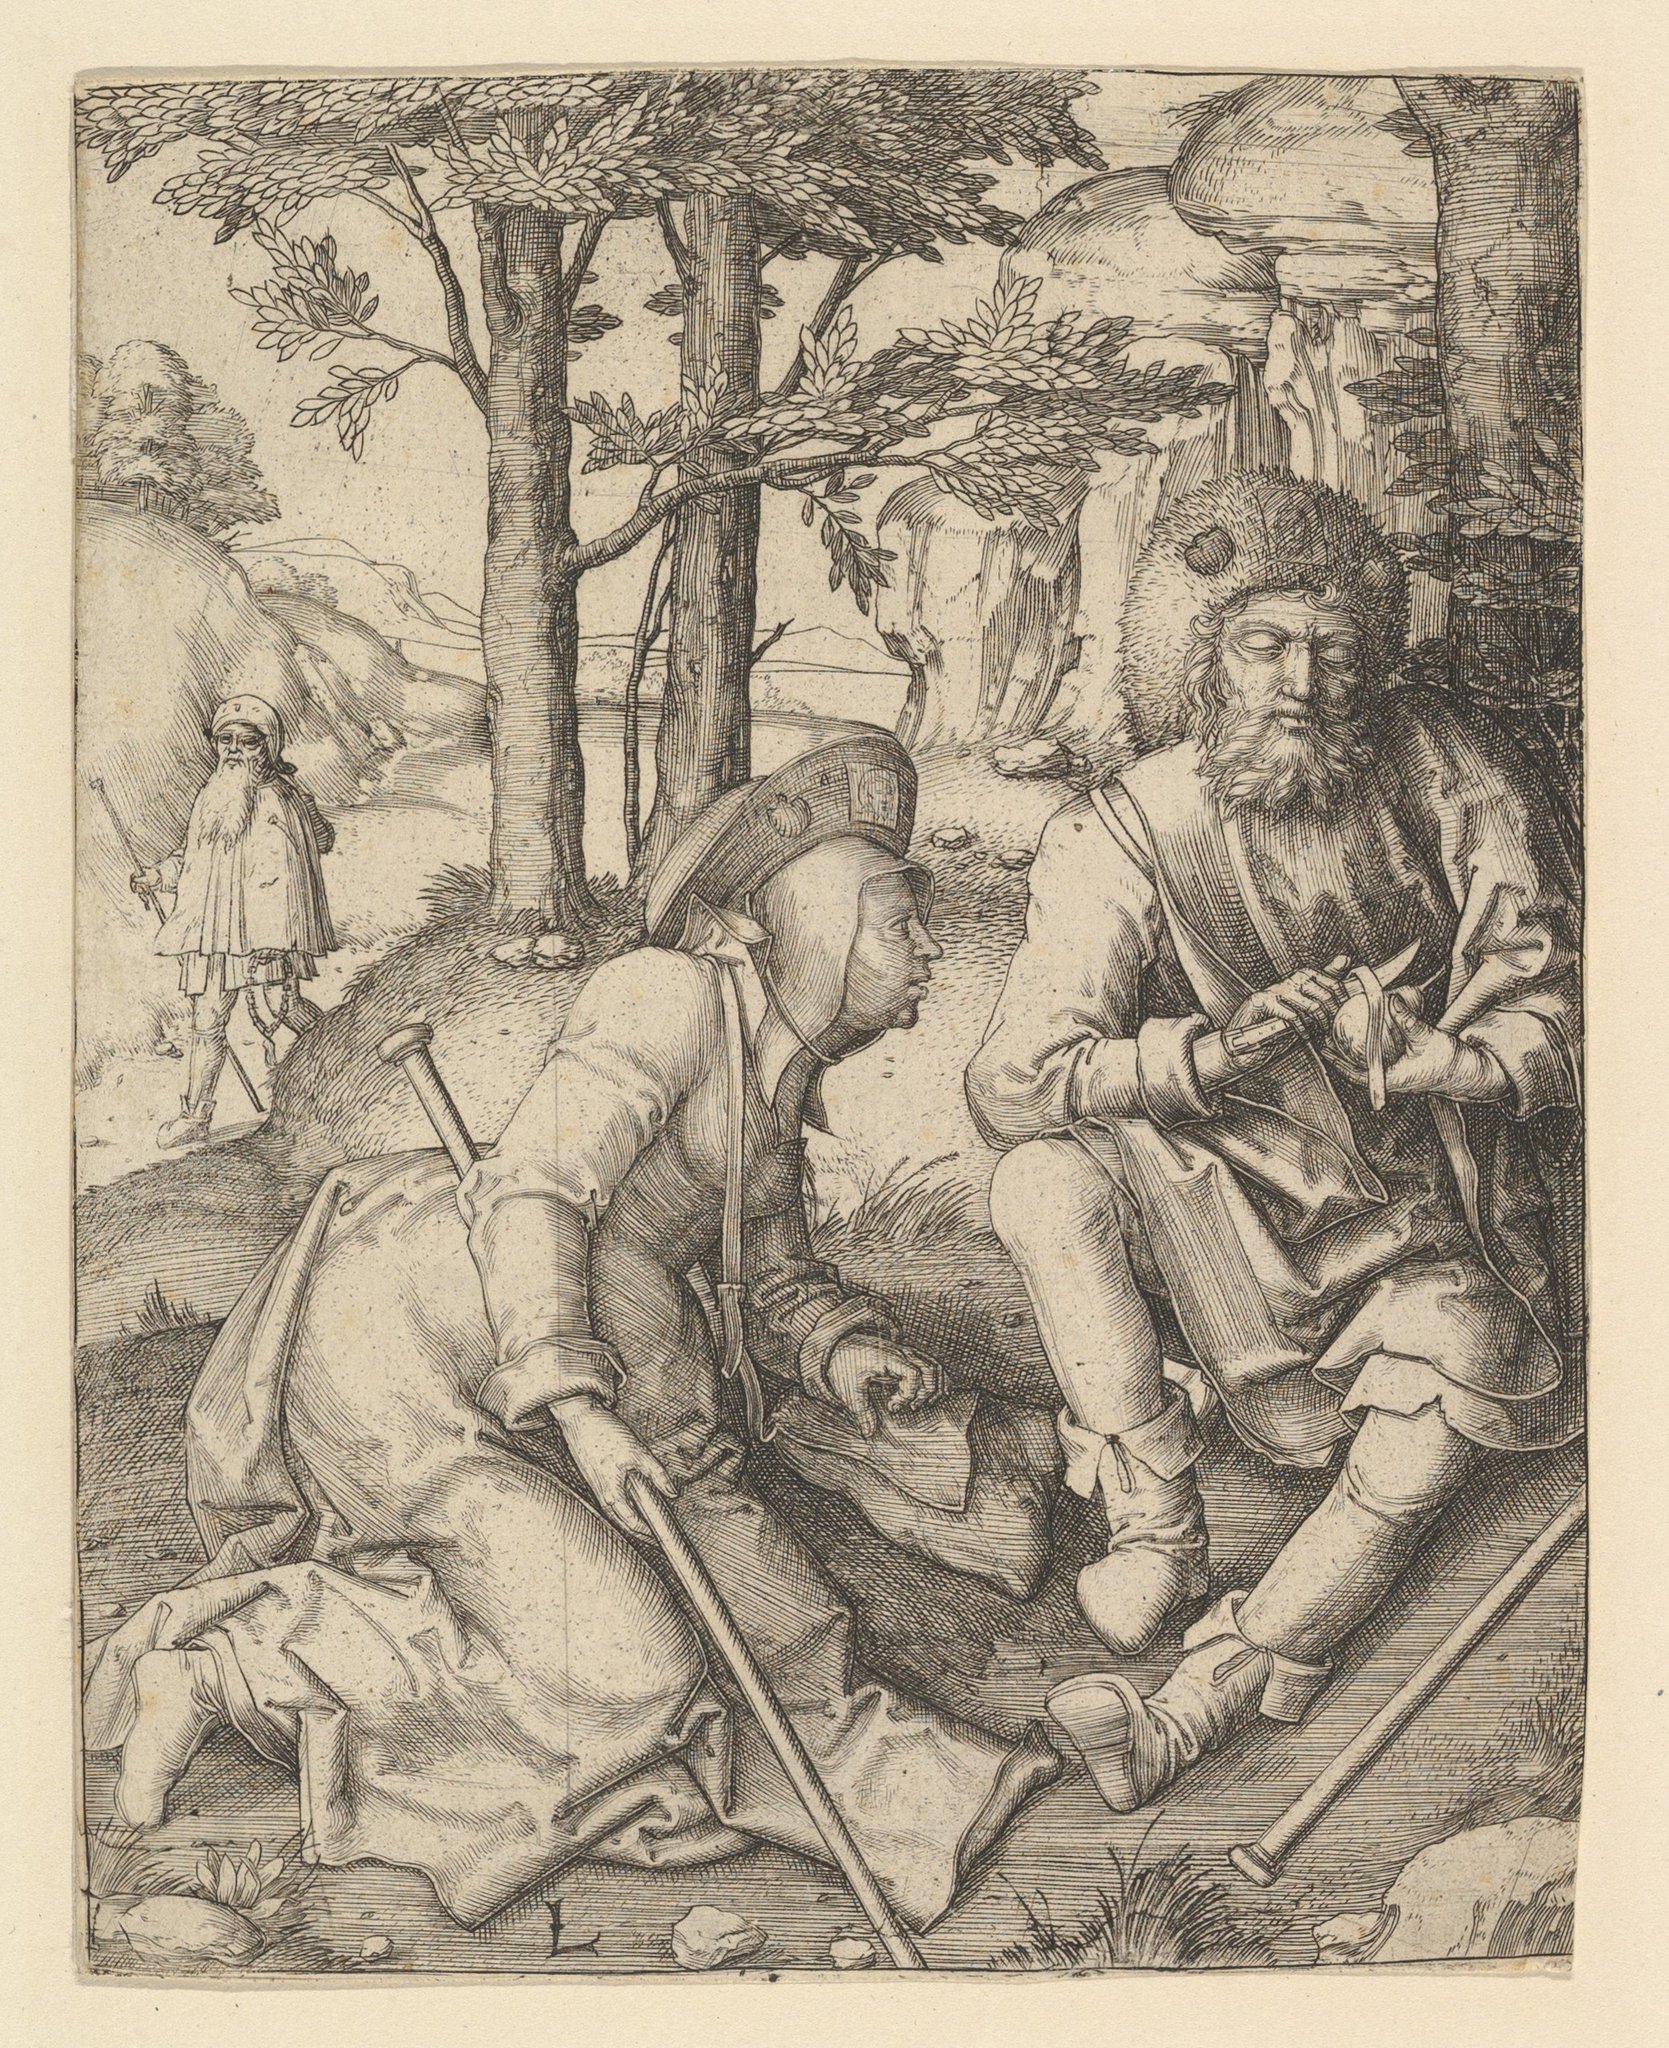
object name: print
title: The Pilgrims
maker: lucas van leyden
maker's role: artist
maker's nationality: netherlandish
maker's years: 1494-1533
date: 1508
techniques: engraving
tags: men,trees